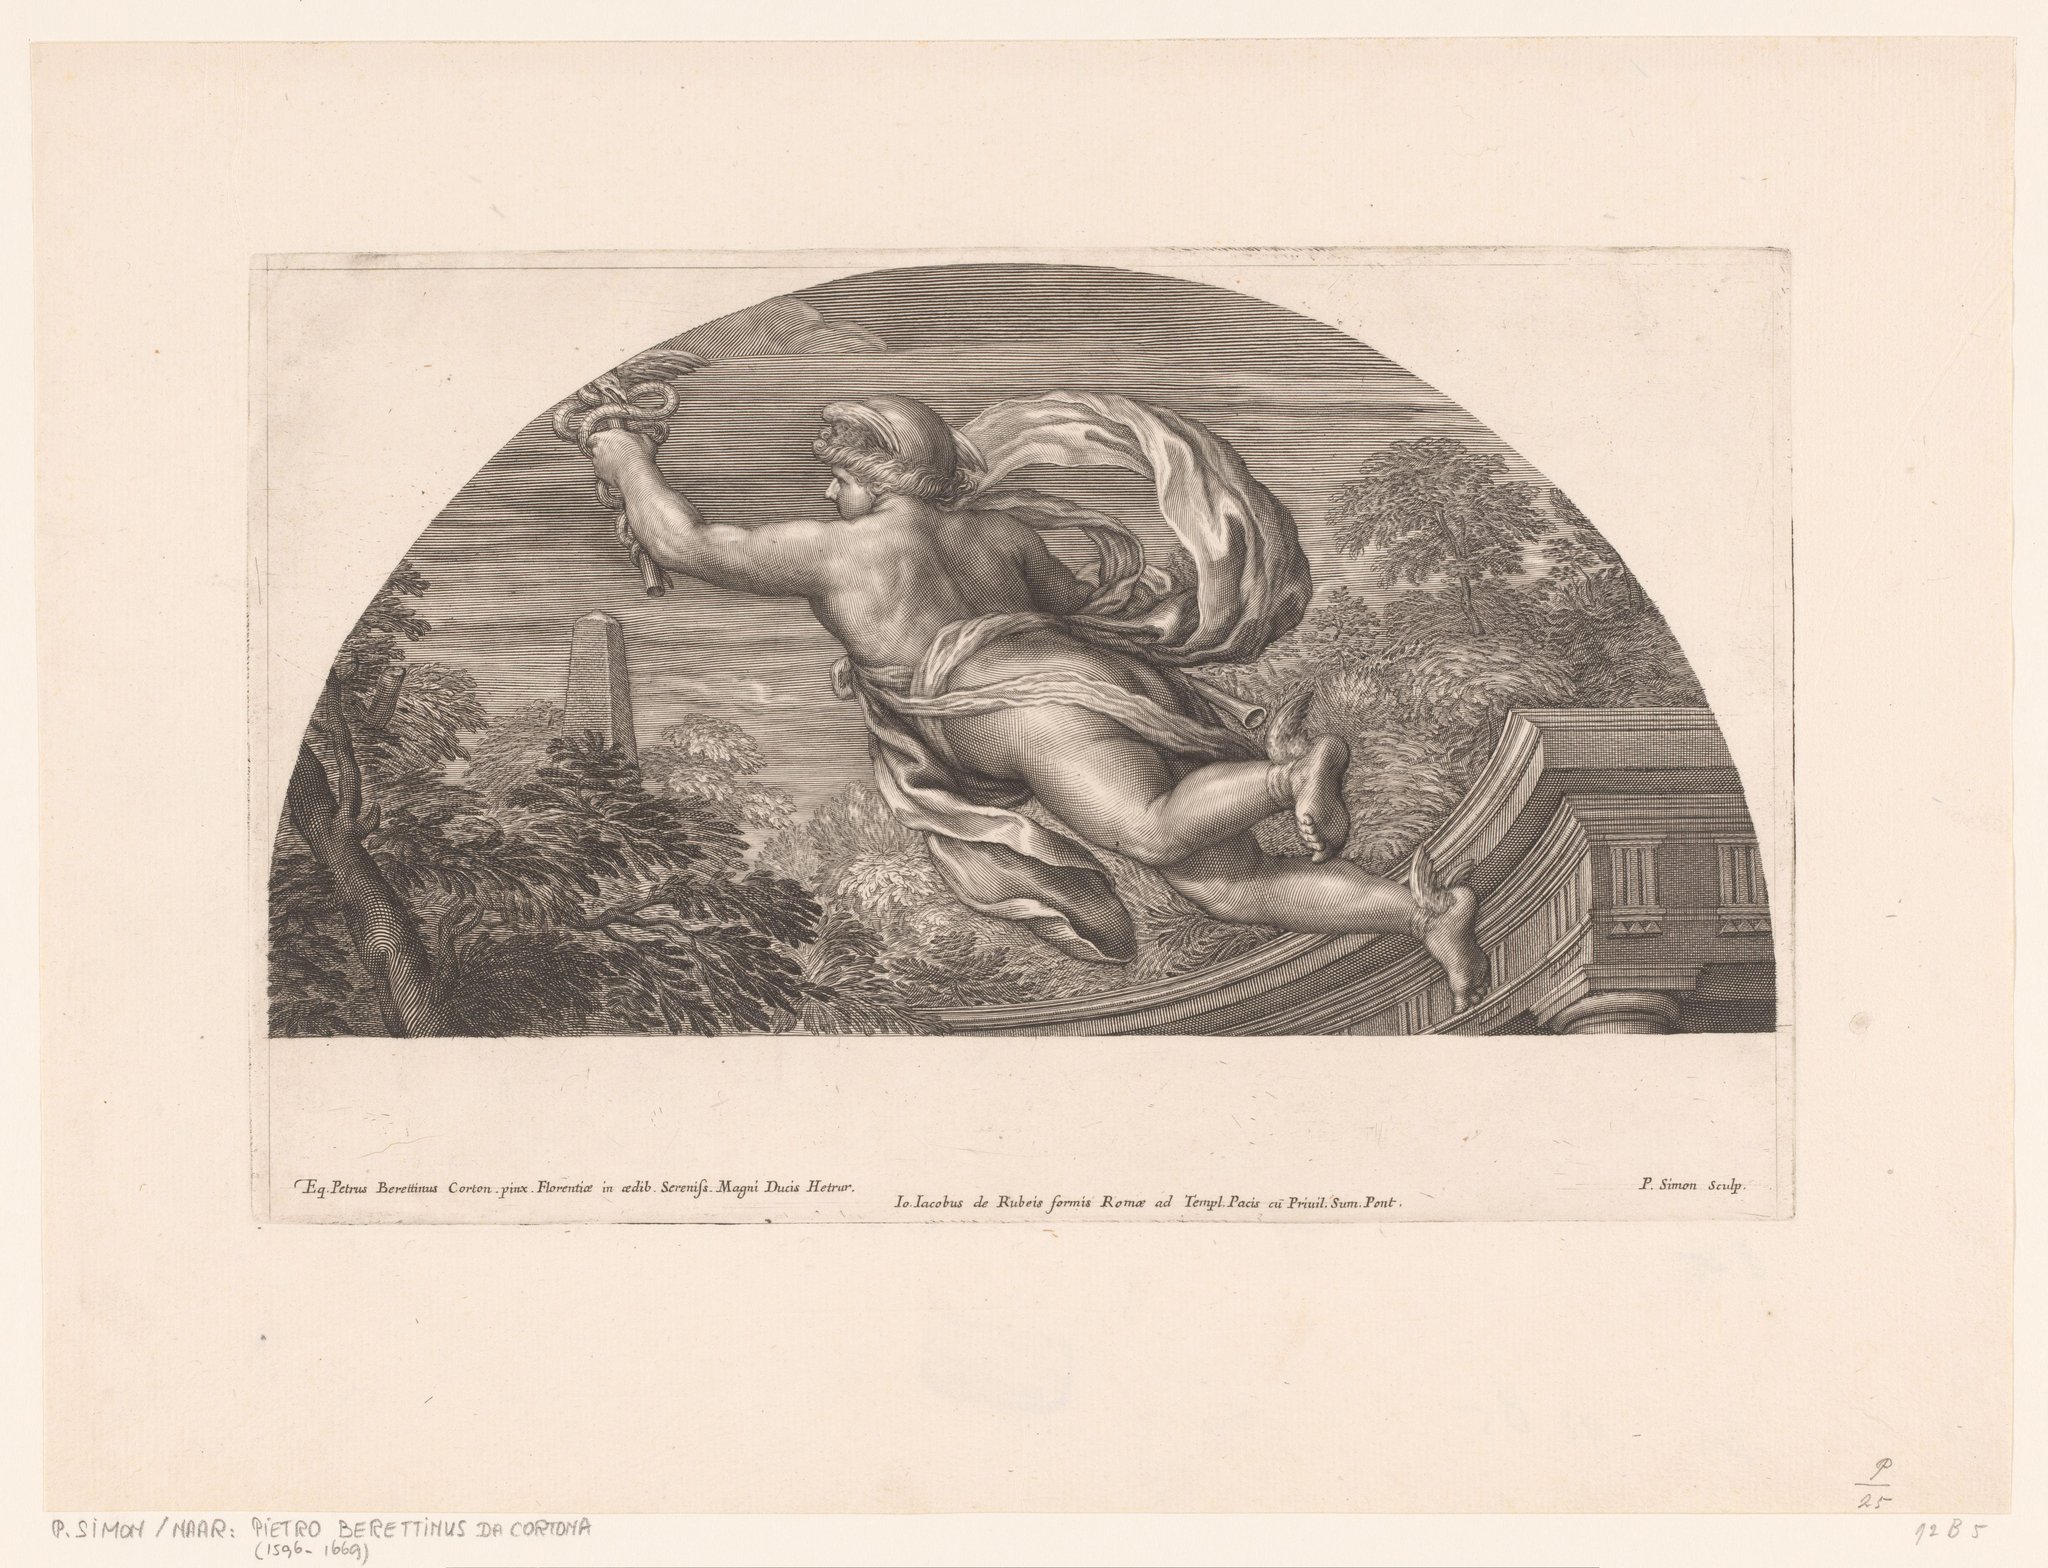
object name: print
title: Vliegende Mercurius, op de rug gezien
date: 1645-1691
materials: paper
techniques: engraving, etching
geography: rome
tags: (story of) mercury (hermes)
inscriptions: collector's mark: Lugt 2228